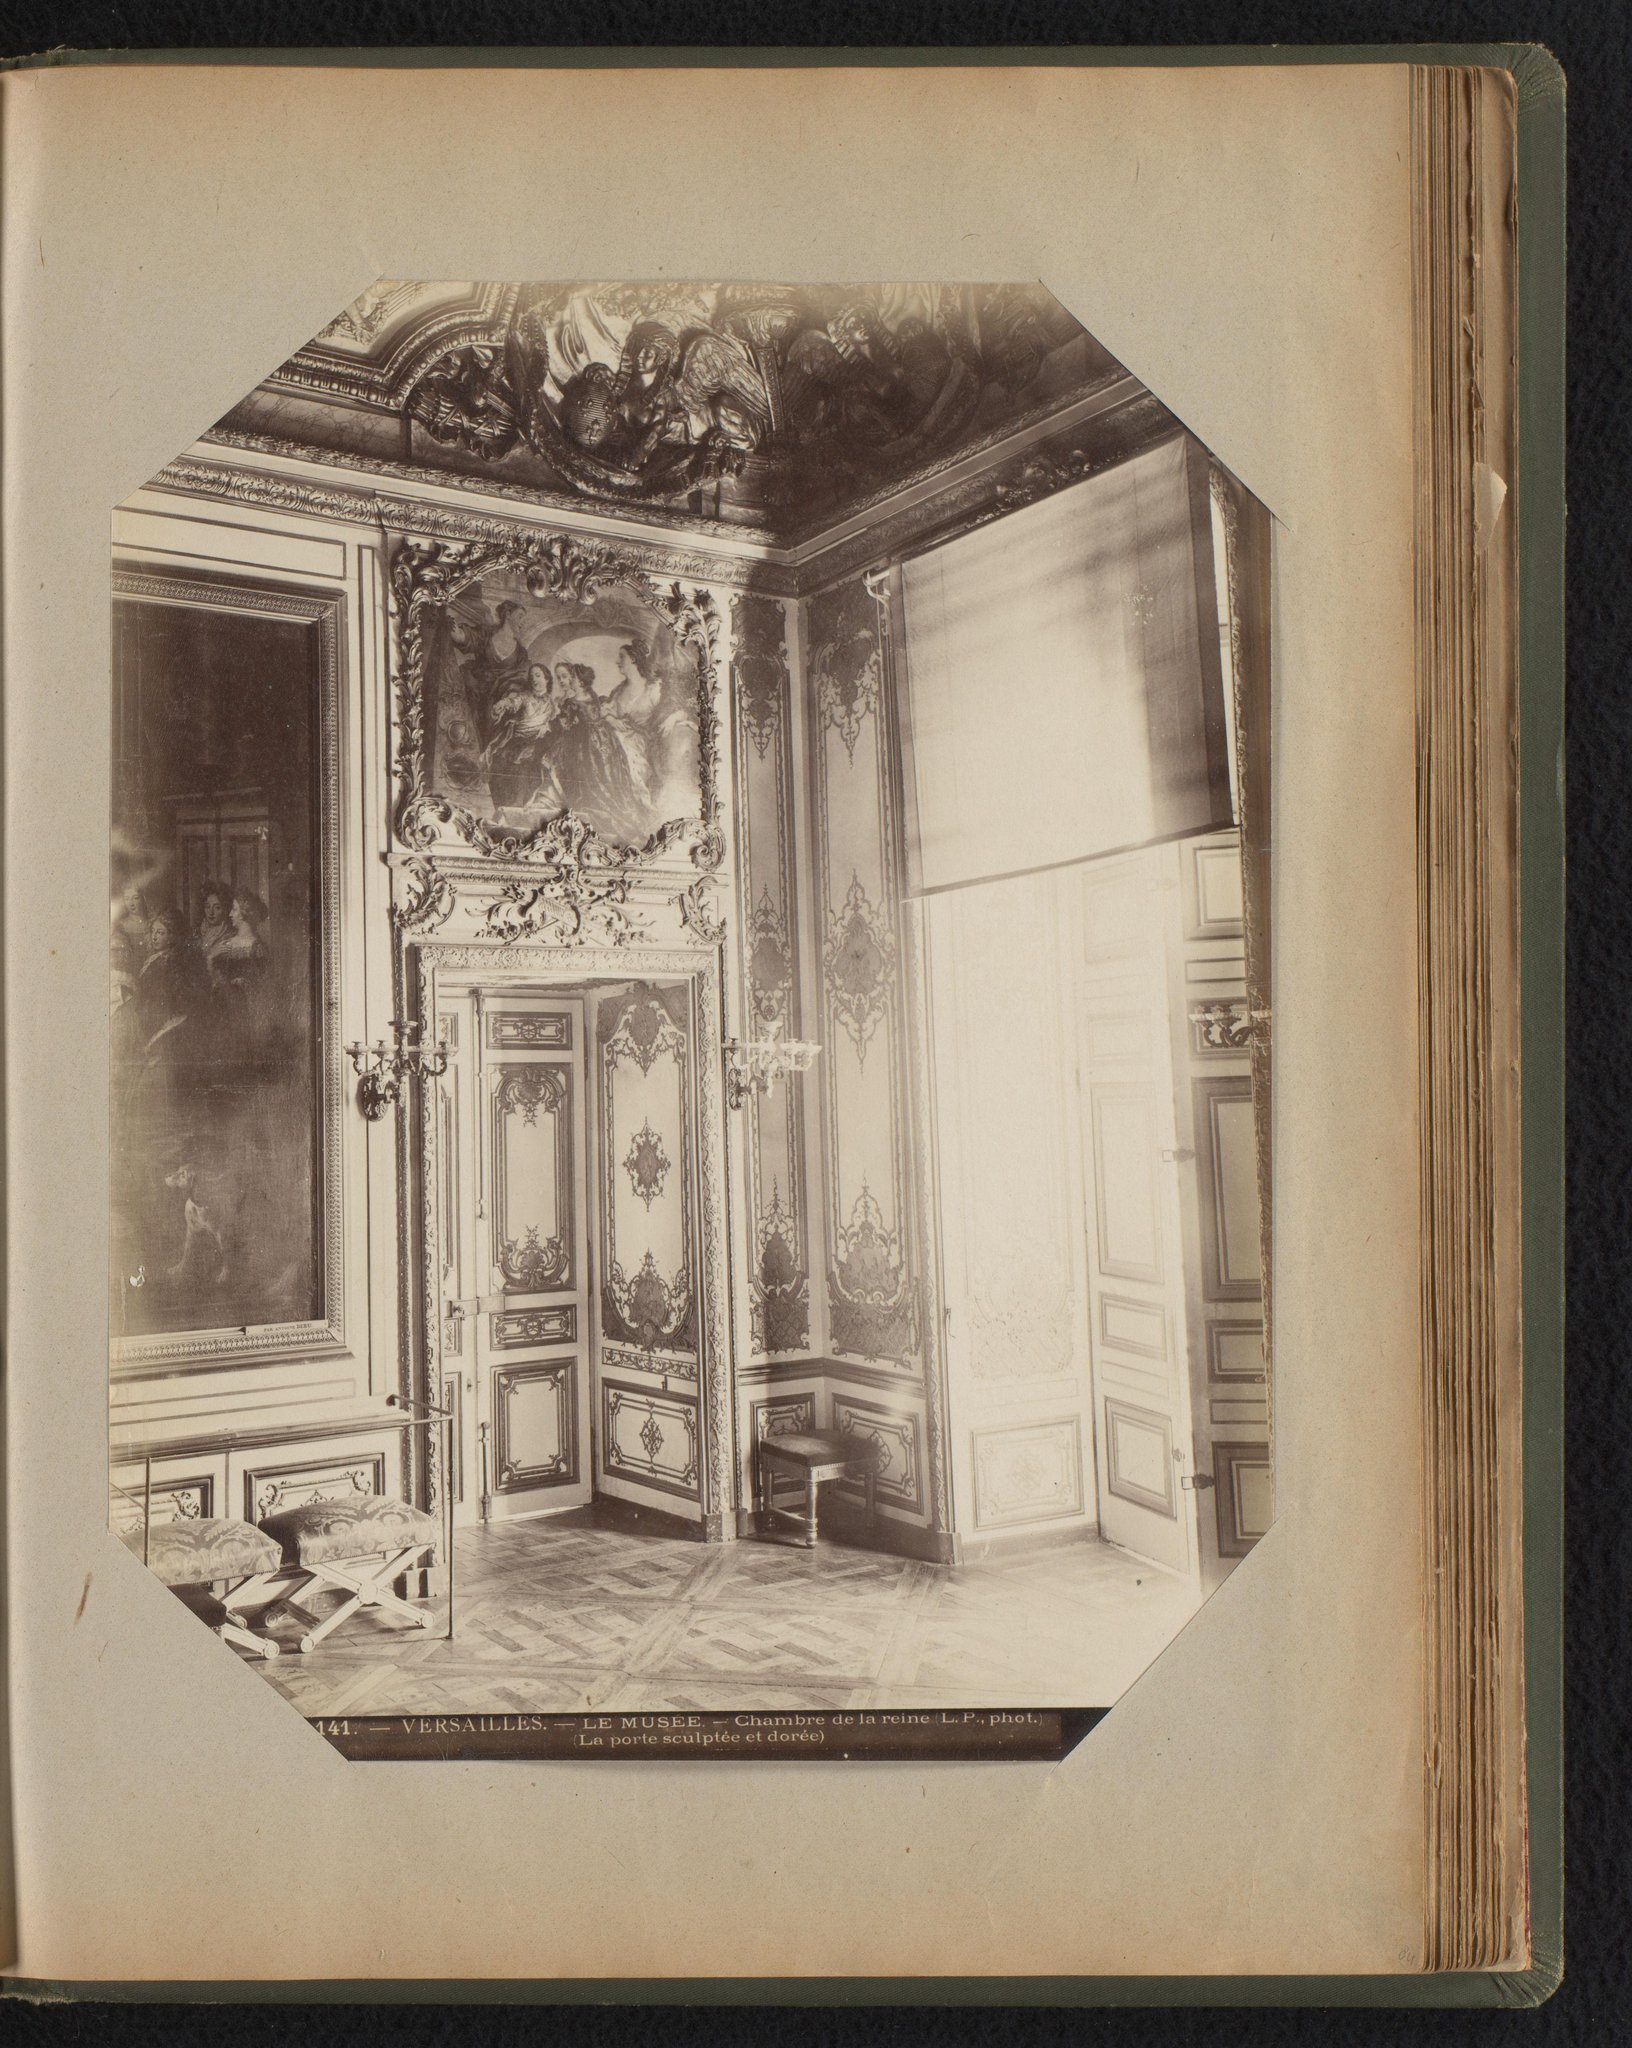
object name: photograph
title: Entree van een kamer met gedecoreerde en vergulde deuren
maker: Anonymous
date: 1860-1900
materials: paper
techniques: albumen print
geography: france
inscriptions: annotation: ‘141. - Versailles. - Le Musee - Chambre de la reine (L.P. Phot) (La porte sculptee et dorée)’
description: Onderdeel van een serie met betrekking tot het interieur van het paleis van Versailles met kroonluchters, deuren, portalen en meubelstukken.